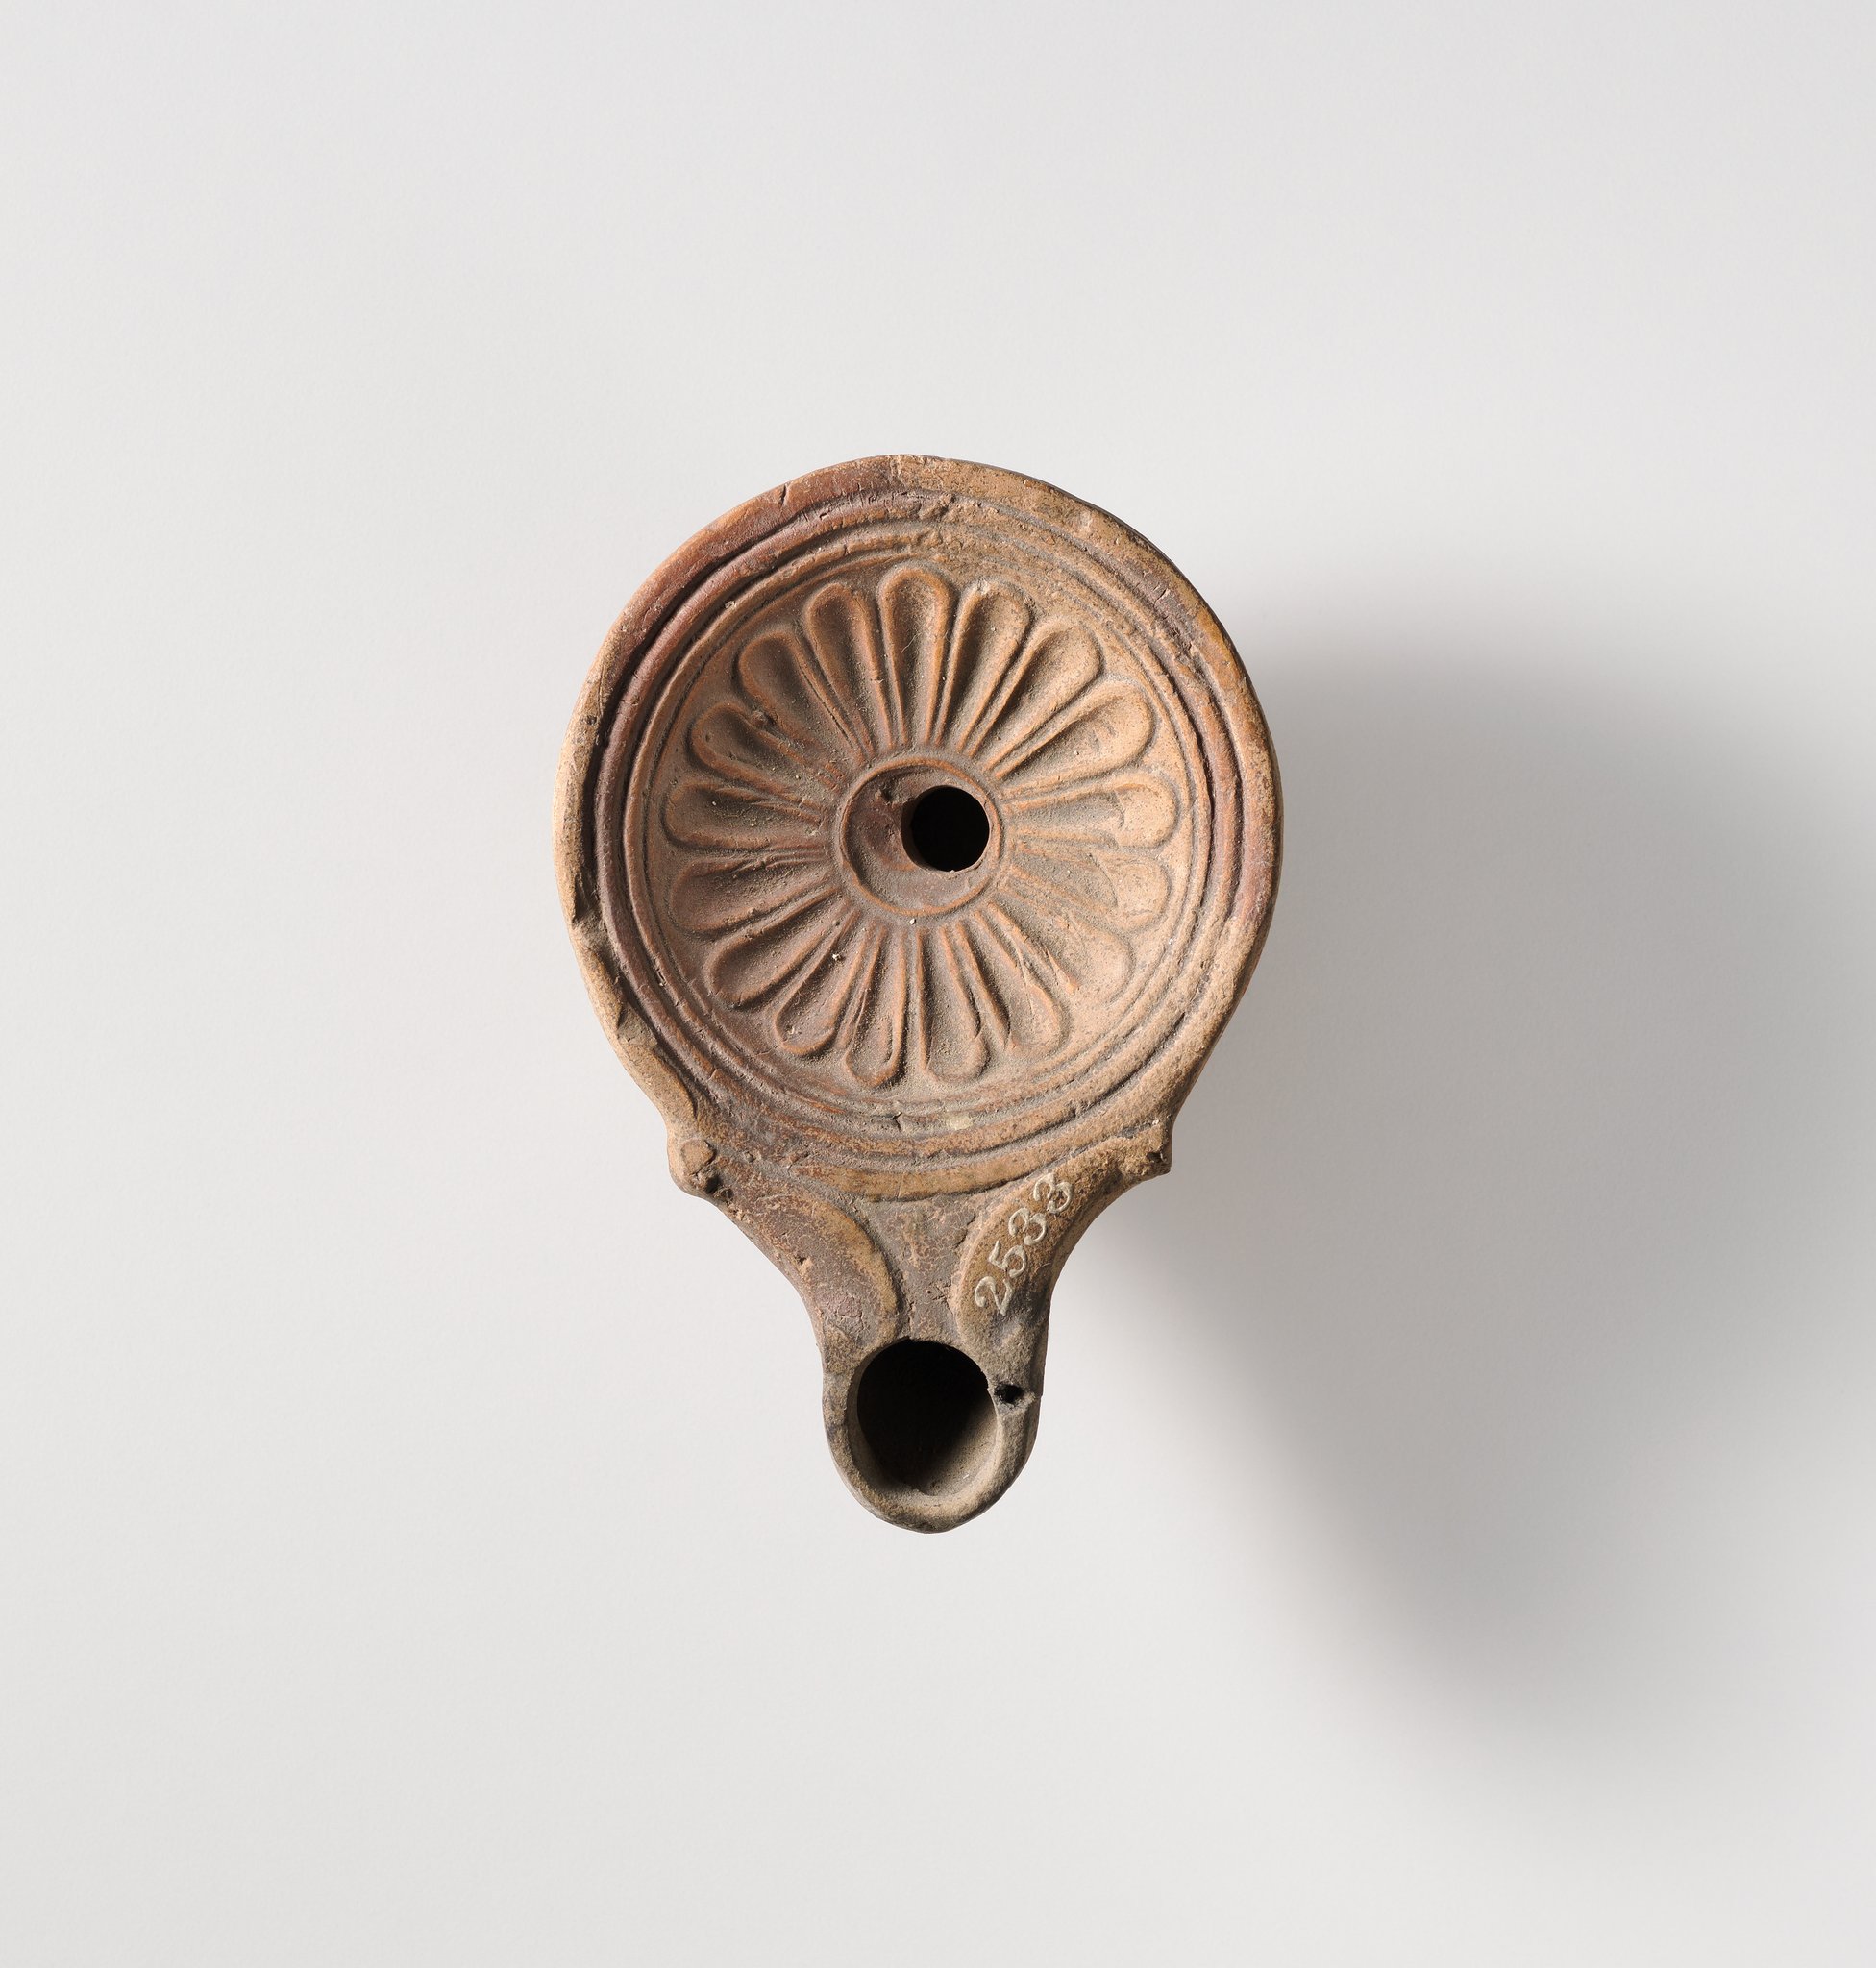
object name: lamp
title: Terracotta oil lamp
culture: roman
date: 100 BCE-100 CE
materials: terracotta